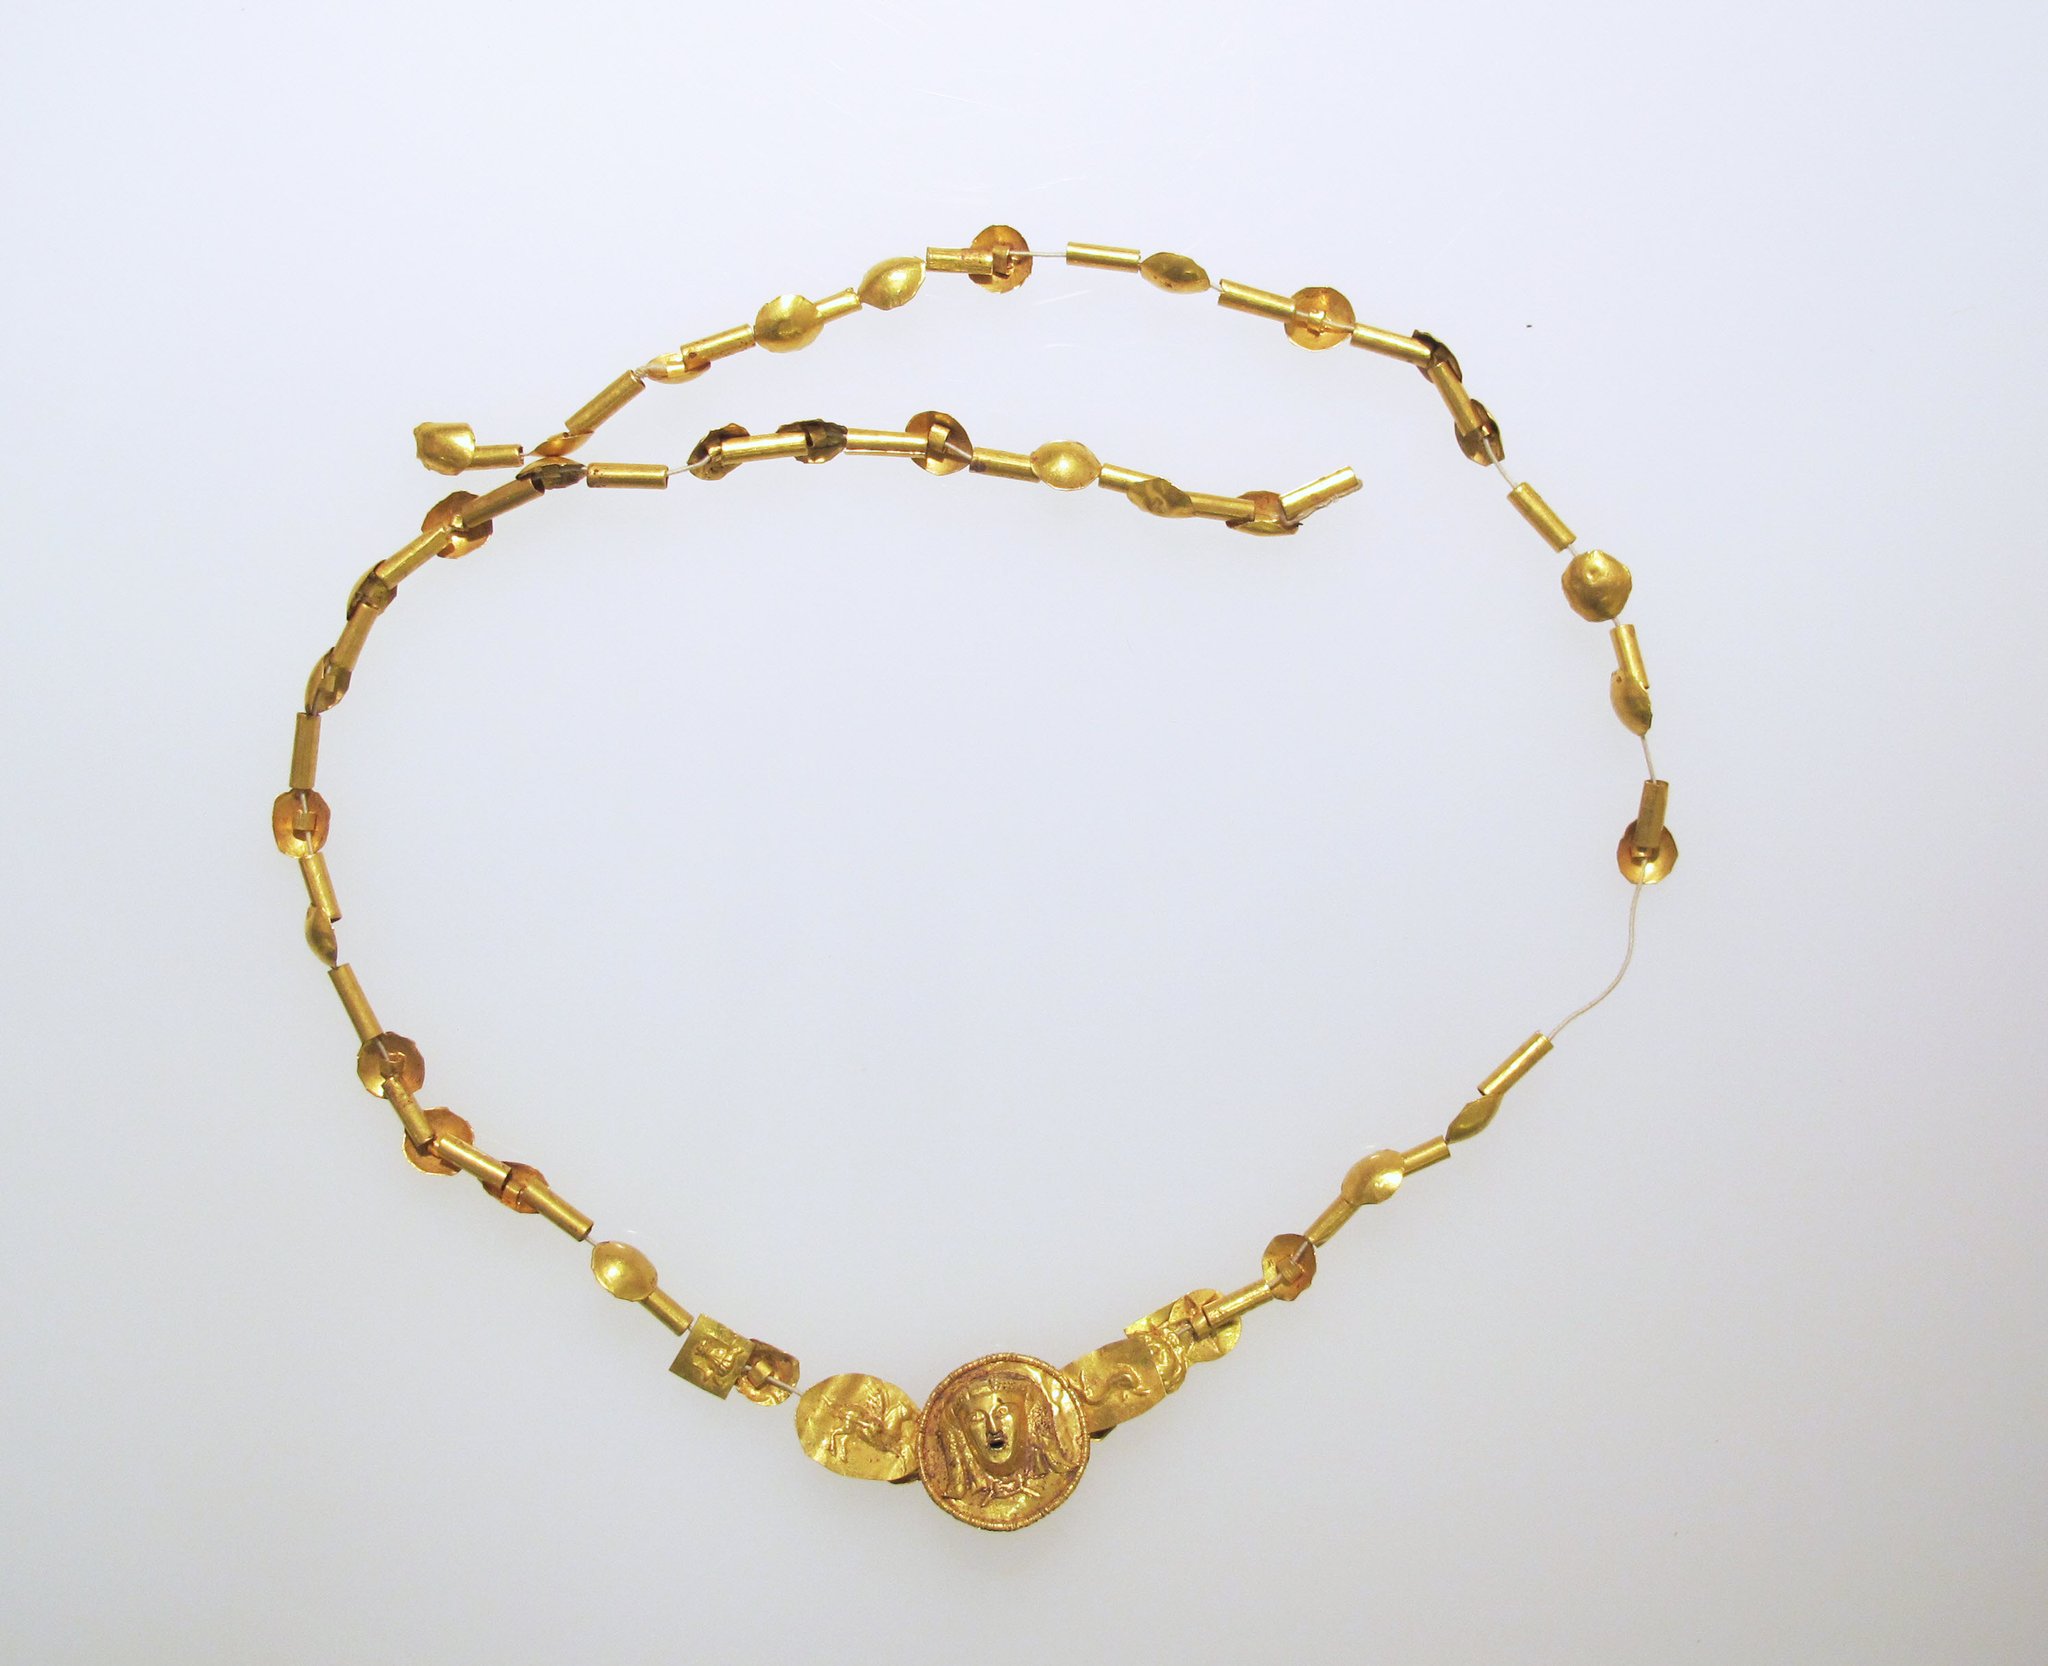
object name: necklace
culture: etruscan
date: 700-401 BCE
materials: gold